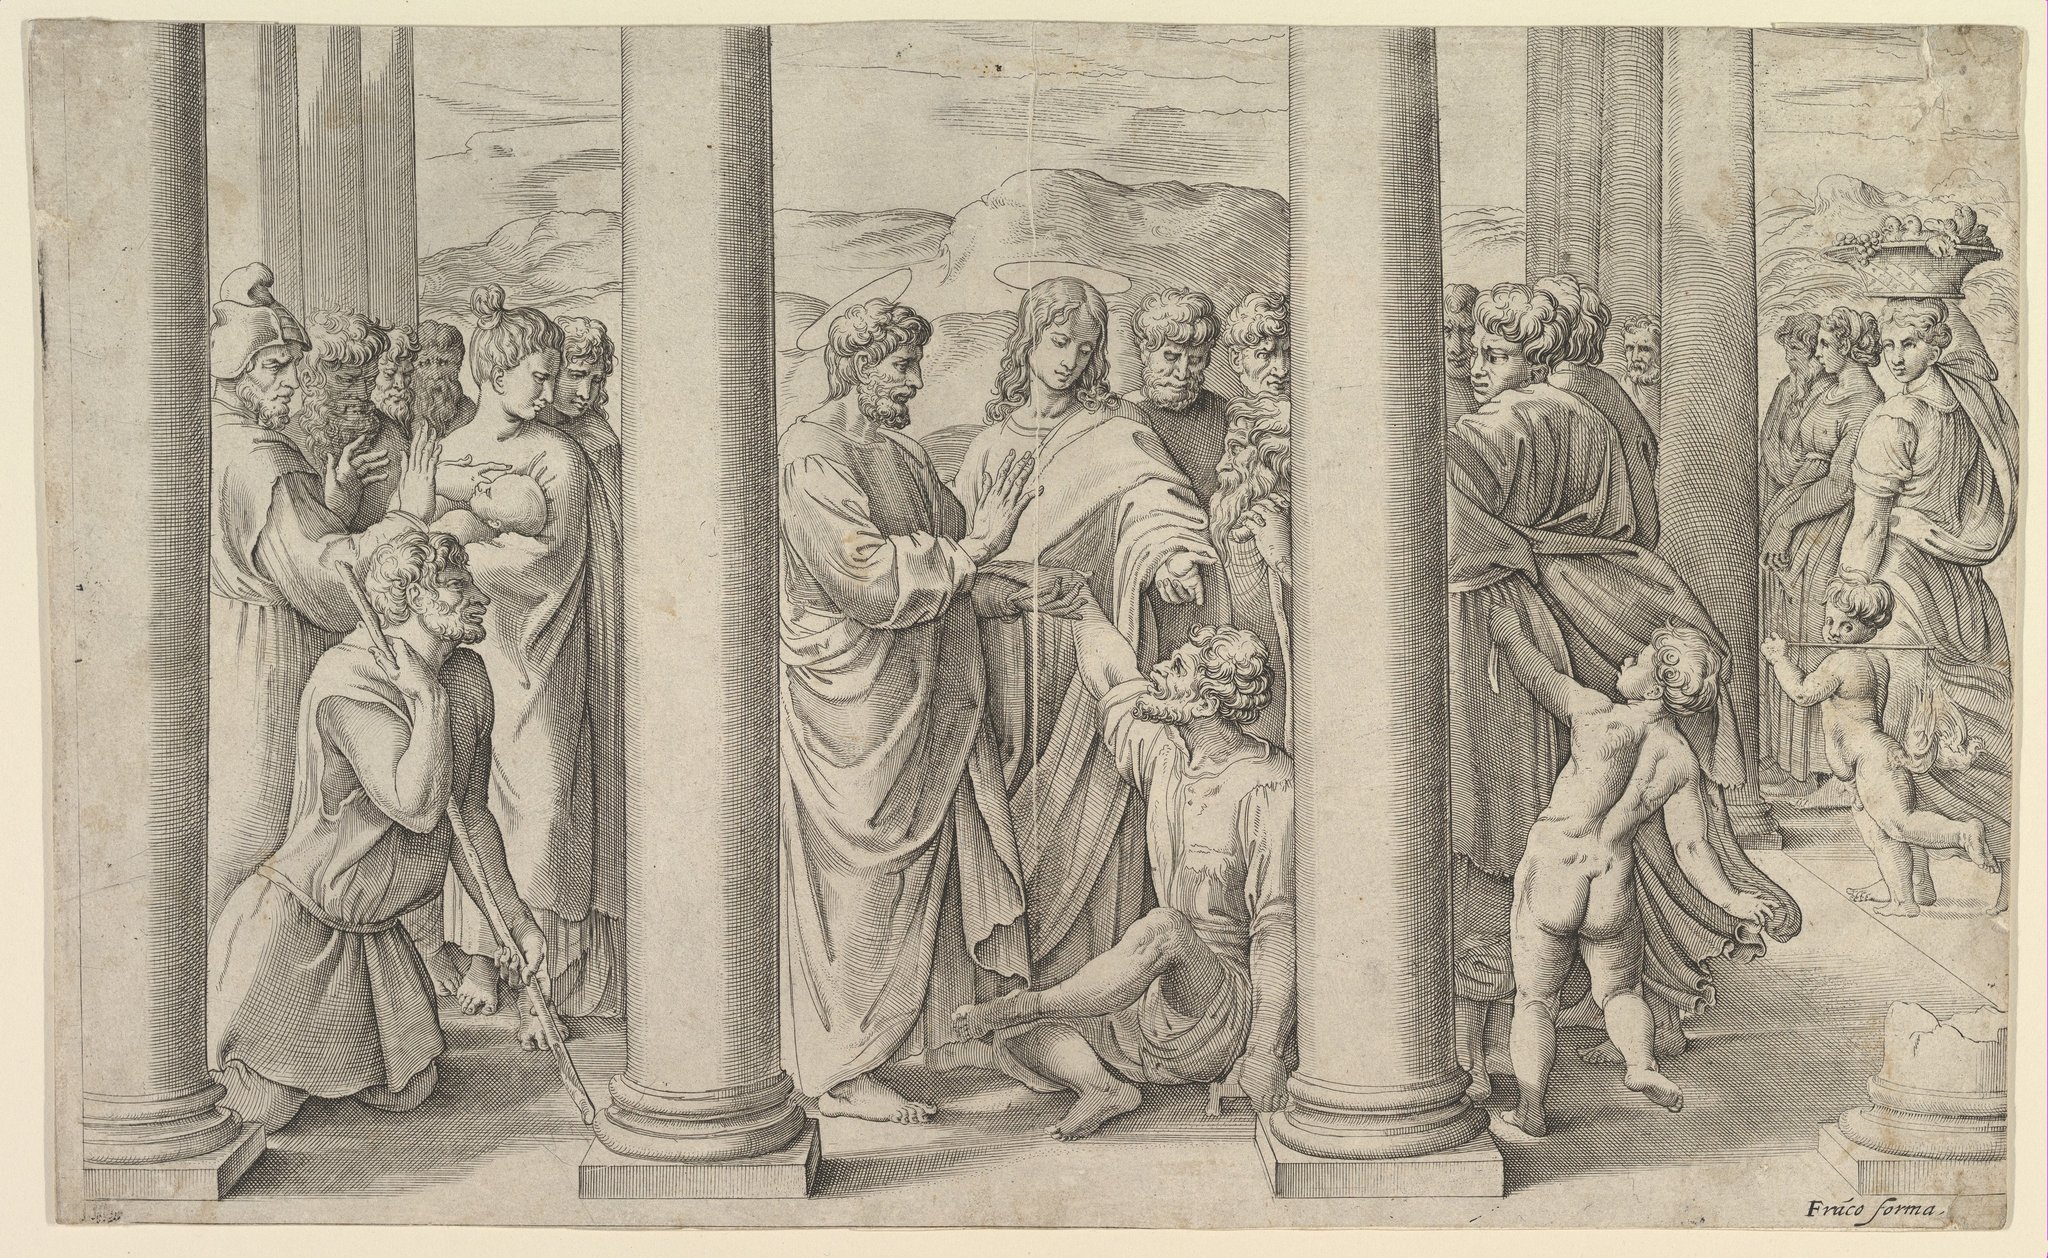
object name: print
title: St. Peter and St. John healing the lame man at the gate of the temple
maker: battista franco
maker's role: artist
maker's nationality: italian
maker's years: 1510-1561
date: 1554-1561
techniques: etching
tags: infants,men,women,saint john the evangelist,saint peter